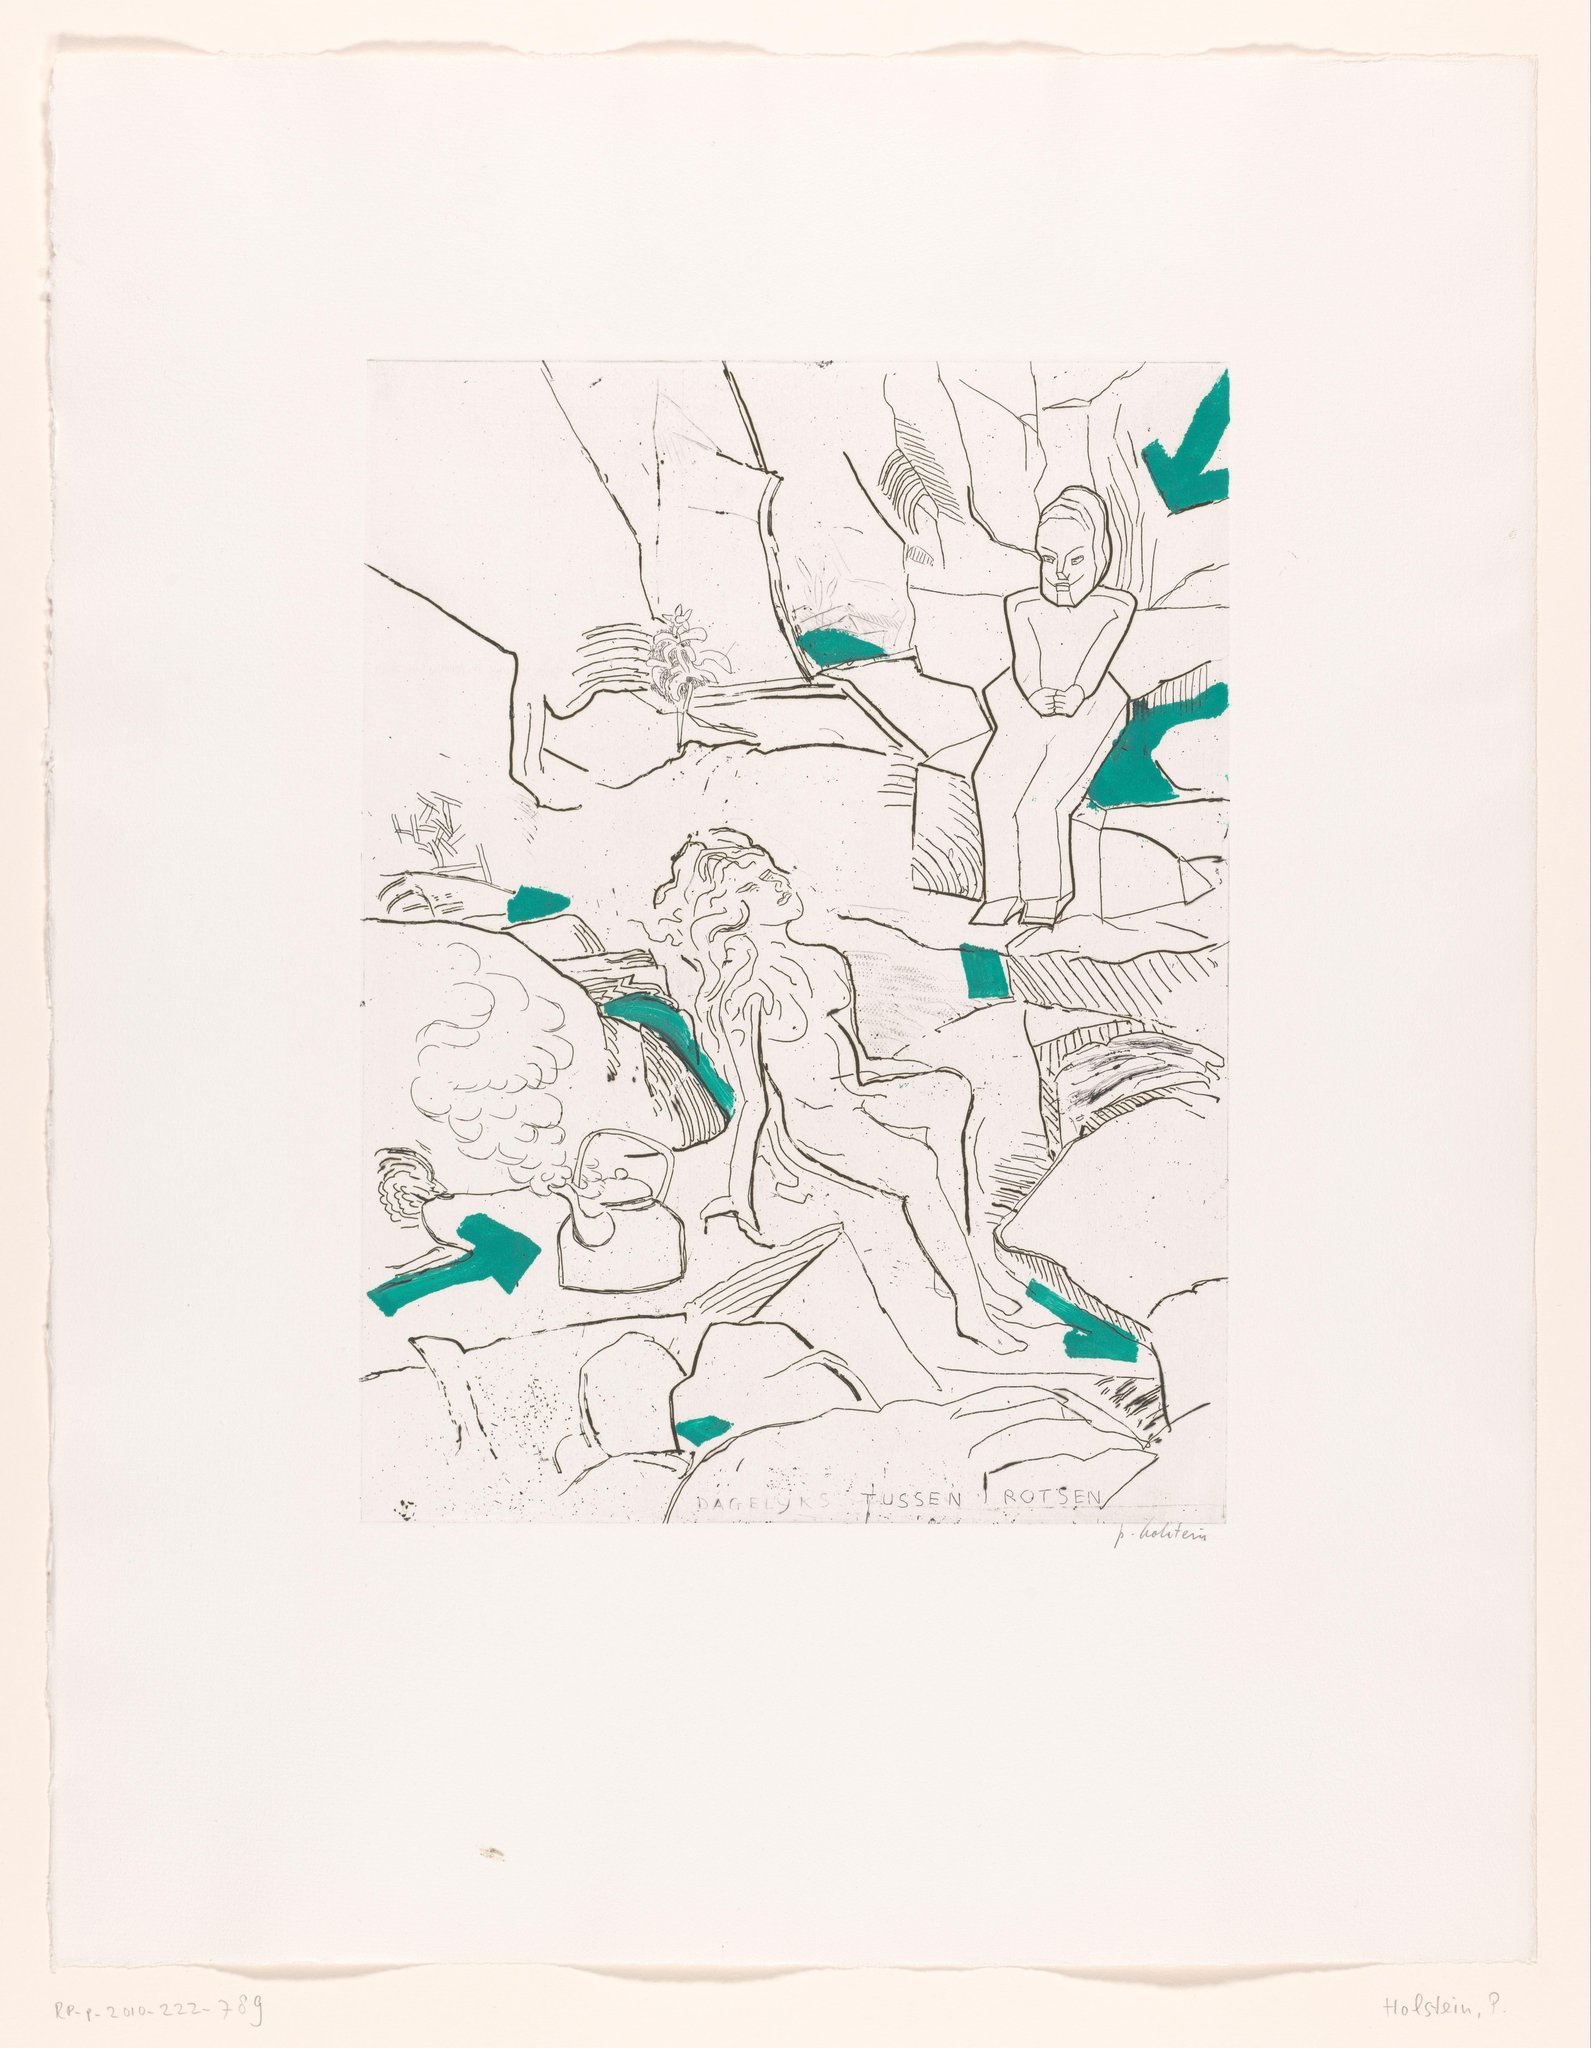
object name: print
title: Dagelijks tussen rotsen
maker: pieter holstein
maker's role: draughtsman, painter, print maker, sculptor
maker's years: 1934-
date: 1986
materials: paper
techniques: aquatint, drypoint, etching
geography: amsterdam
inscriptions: title: ‘DAGELIJKS TUSSEN ROTSEN’, signature: ‘p. holstein’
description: De serietitel is door het museum toegekend bij gebrek aan informatie over een originele serietitel.